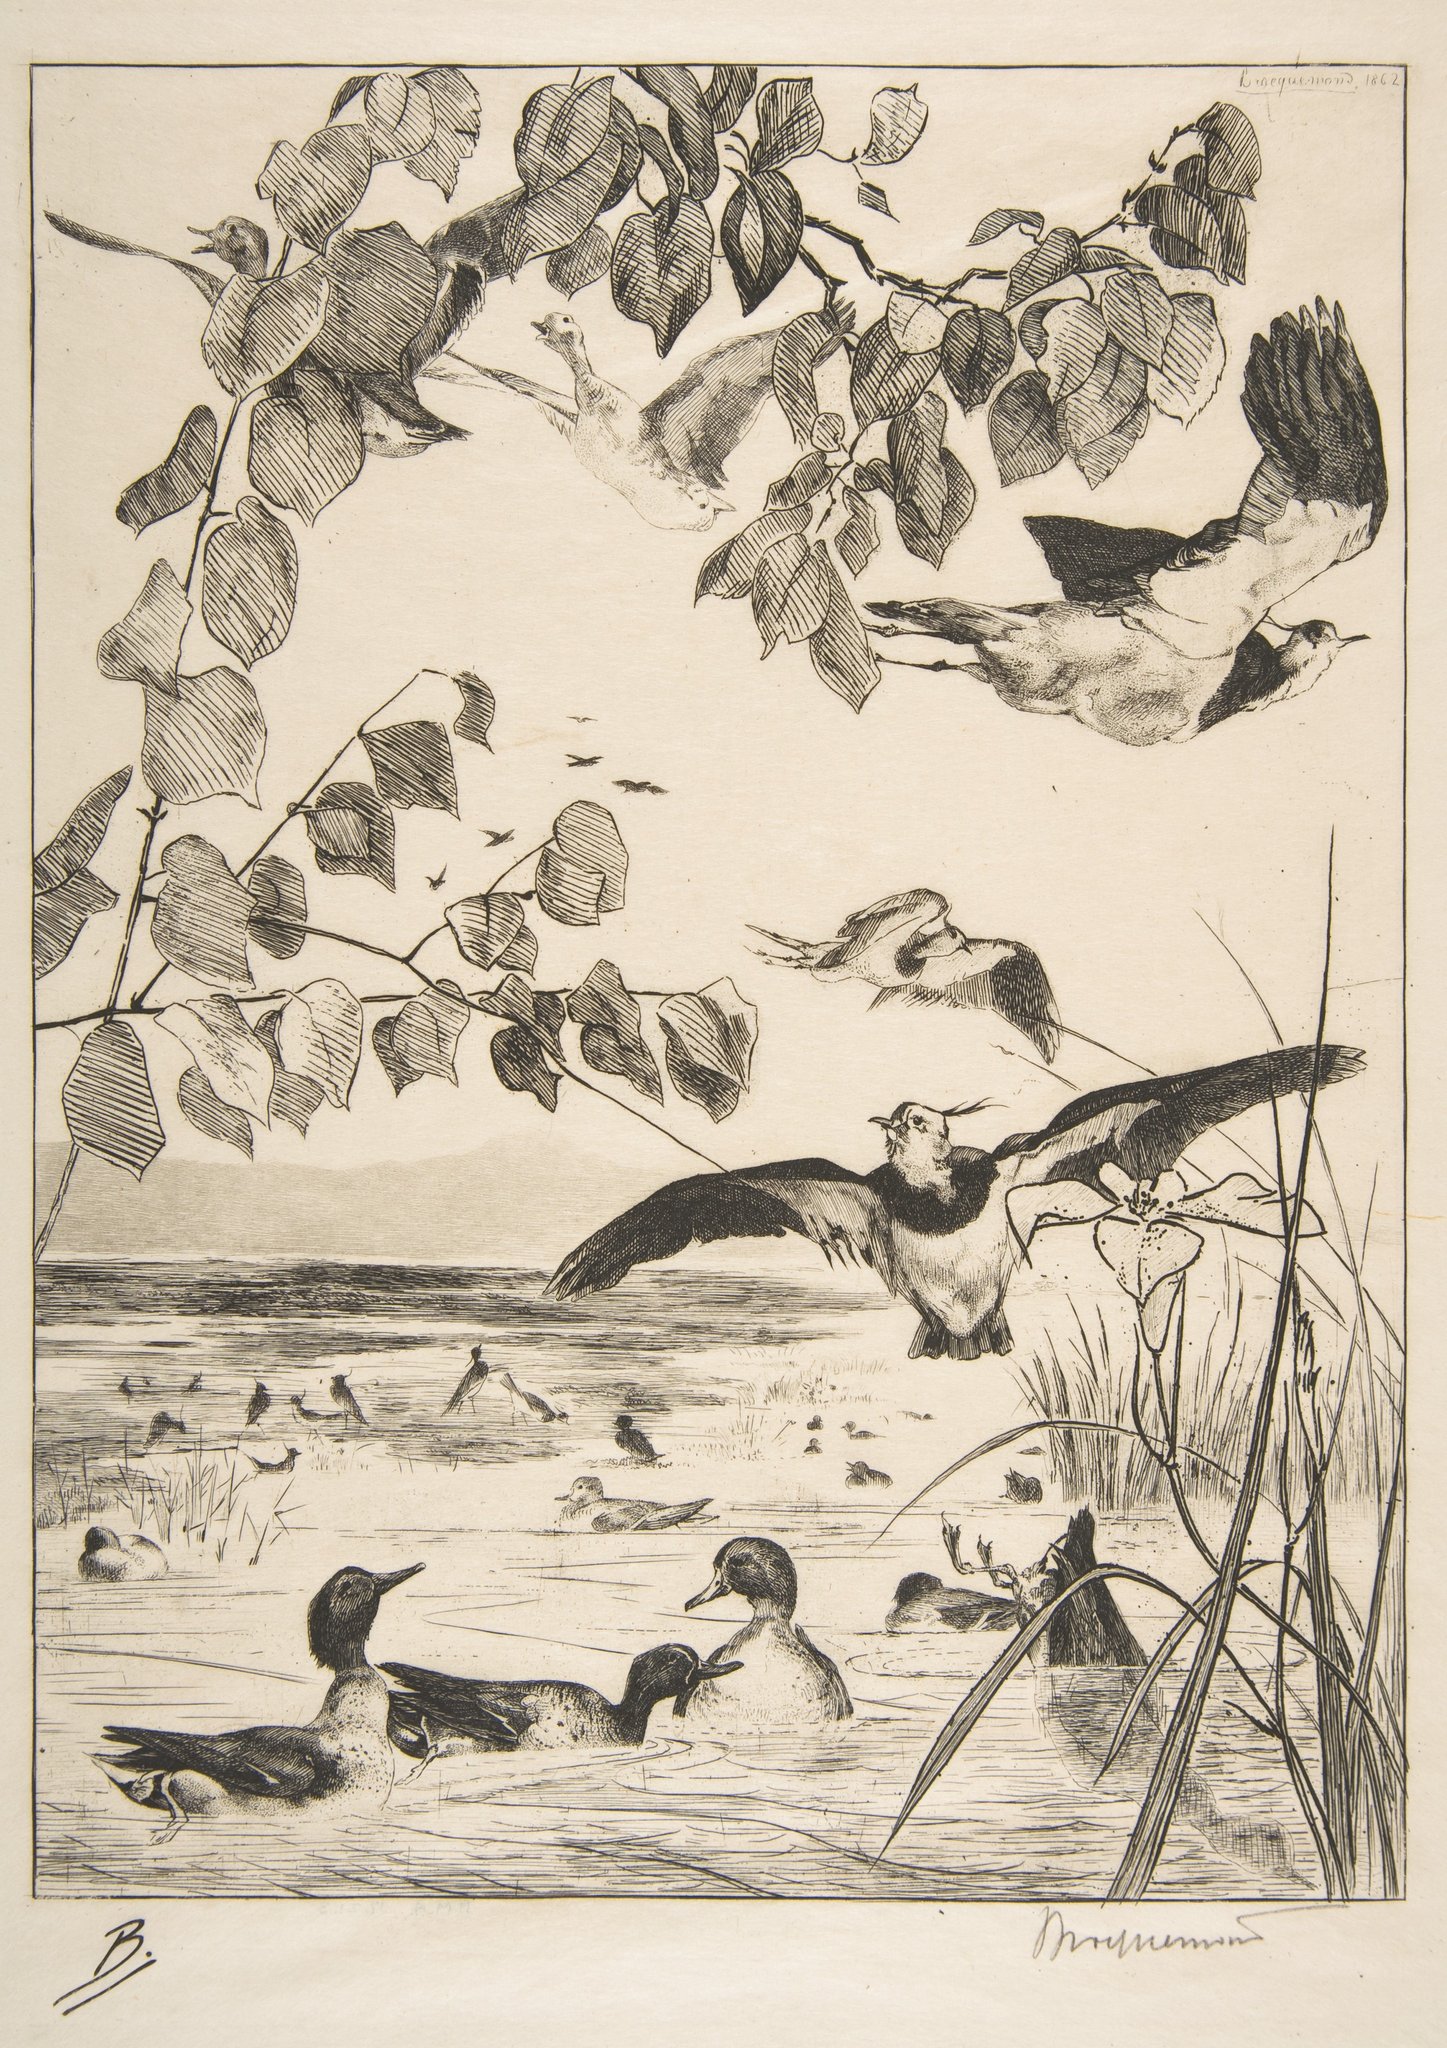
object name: print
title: Vanneaux et Sarcelles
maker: félix bracquemond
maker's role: artist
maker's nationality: french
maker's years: 1833-1914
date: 1862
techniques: etching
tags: birds